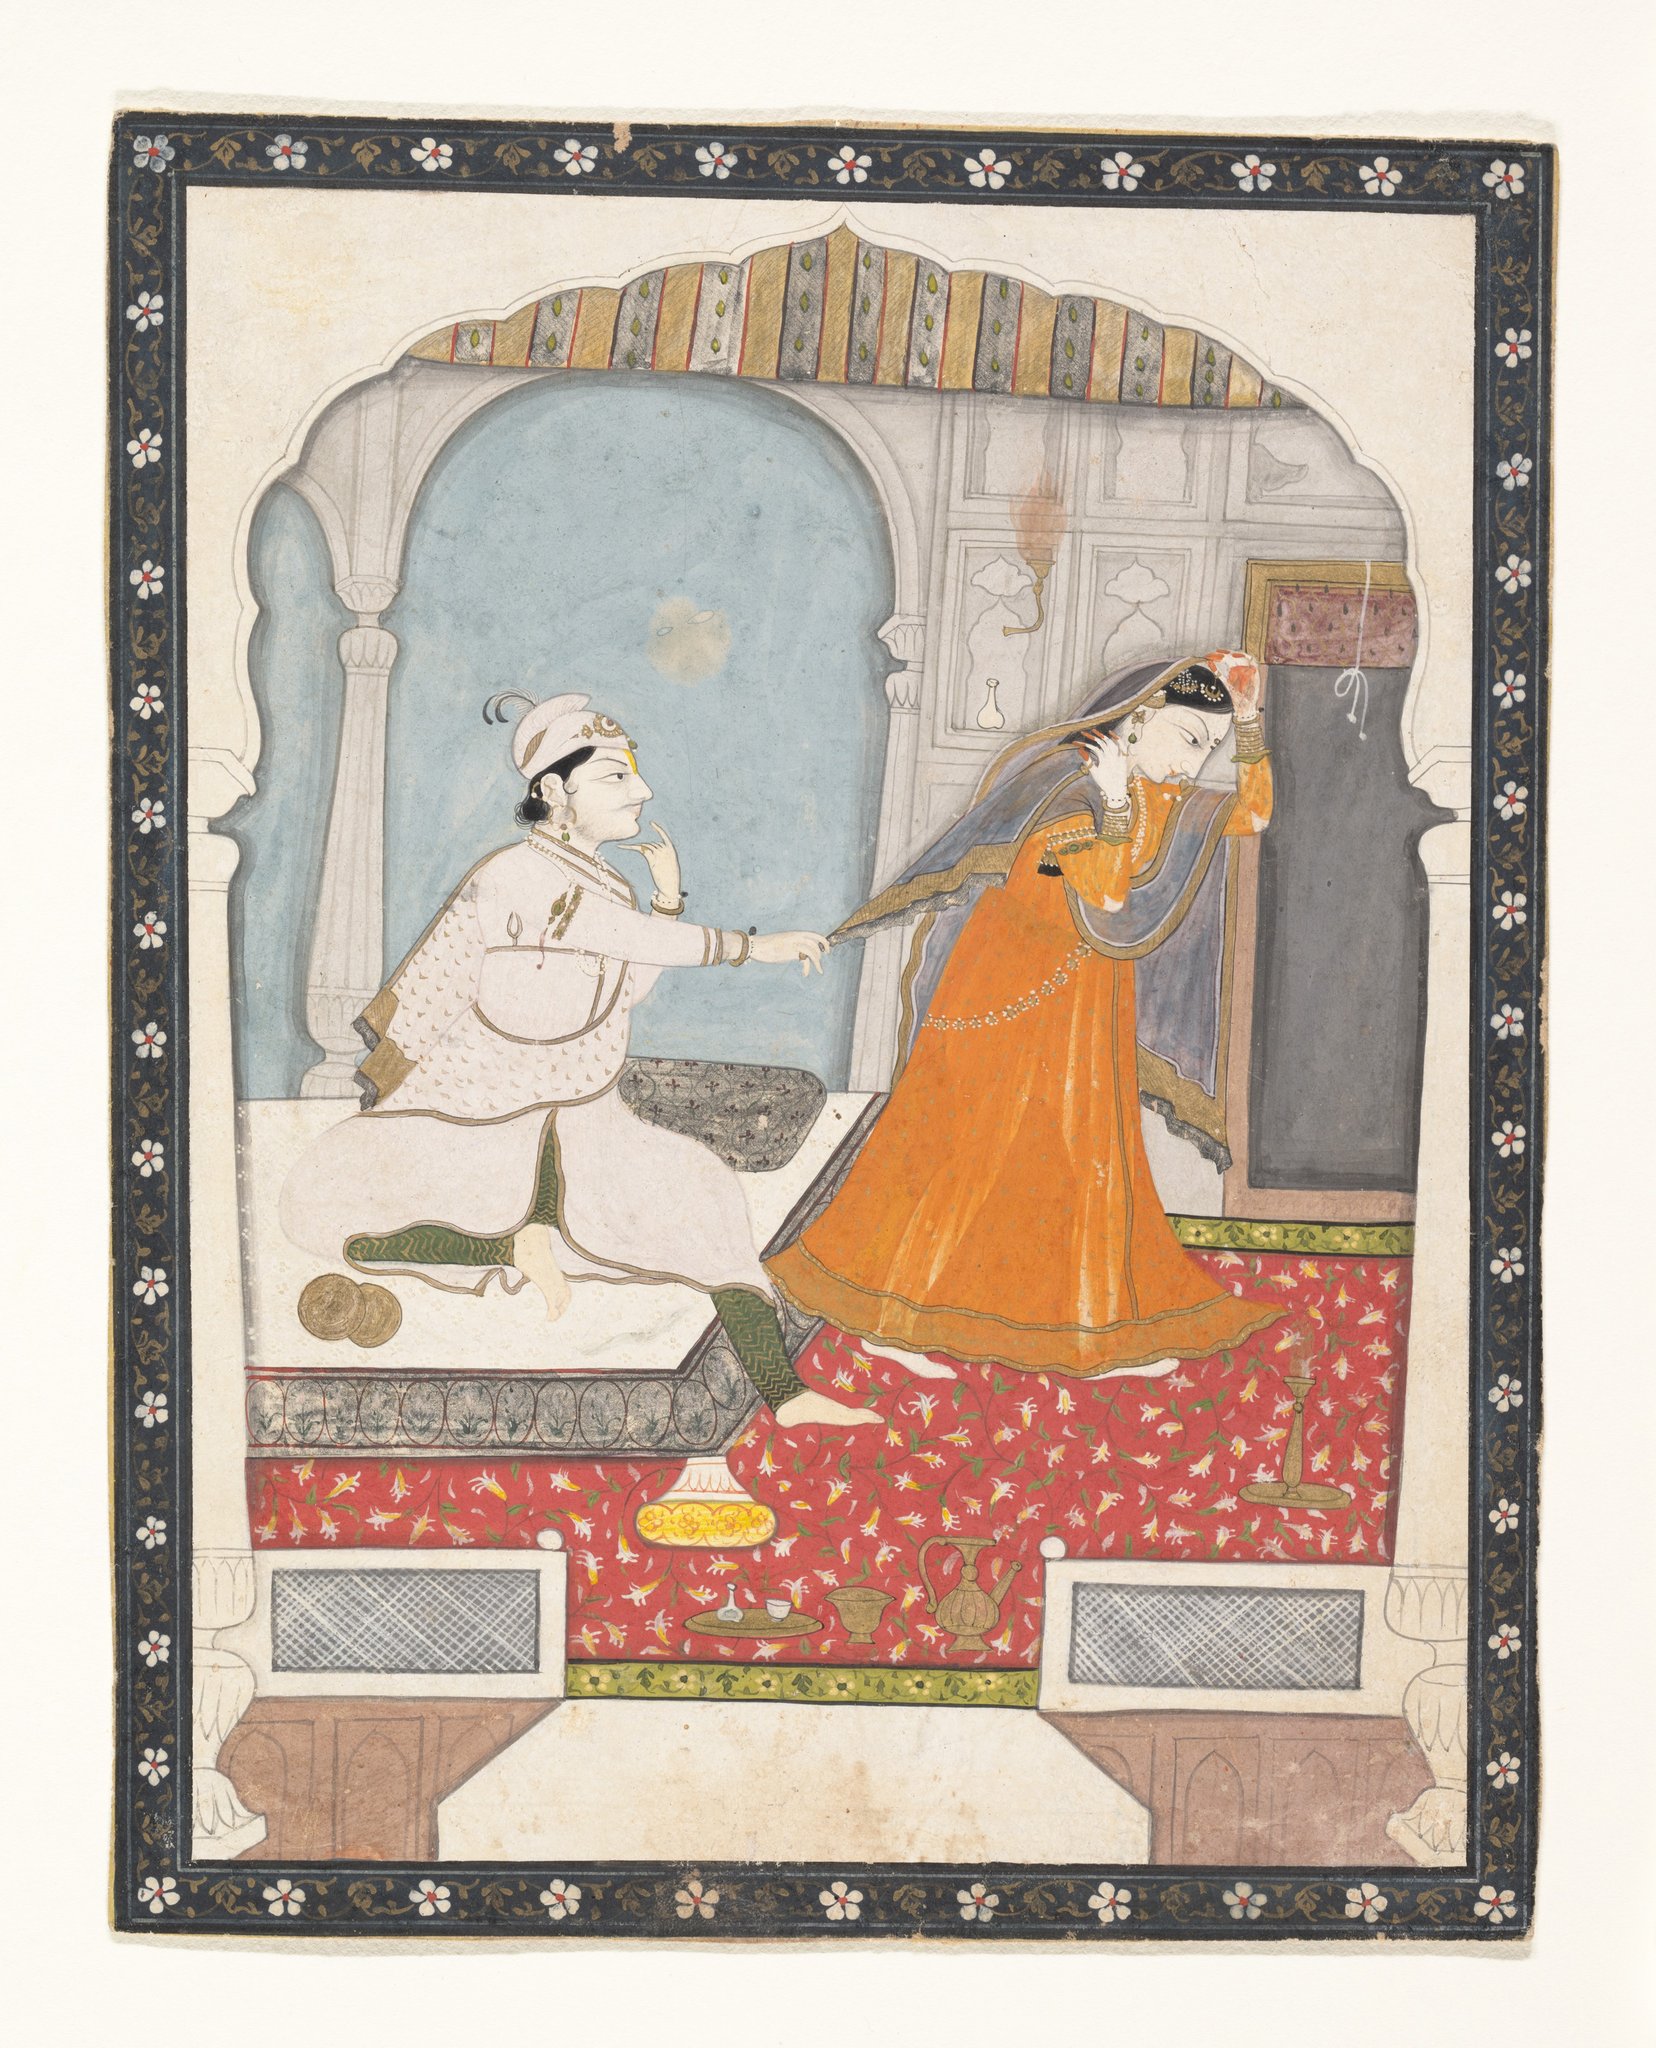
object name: painting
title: The Timid Bride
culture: indian, kangra, punjab hills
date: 1800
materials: gilt, ink, paper, watercolor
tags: couples,men,women